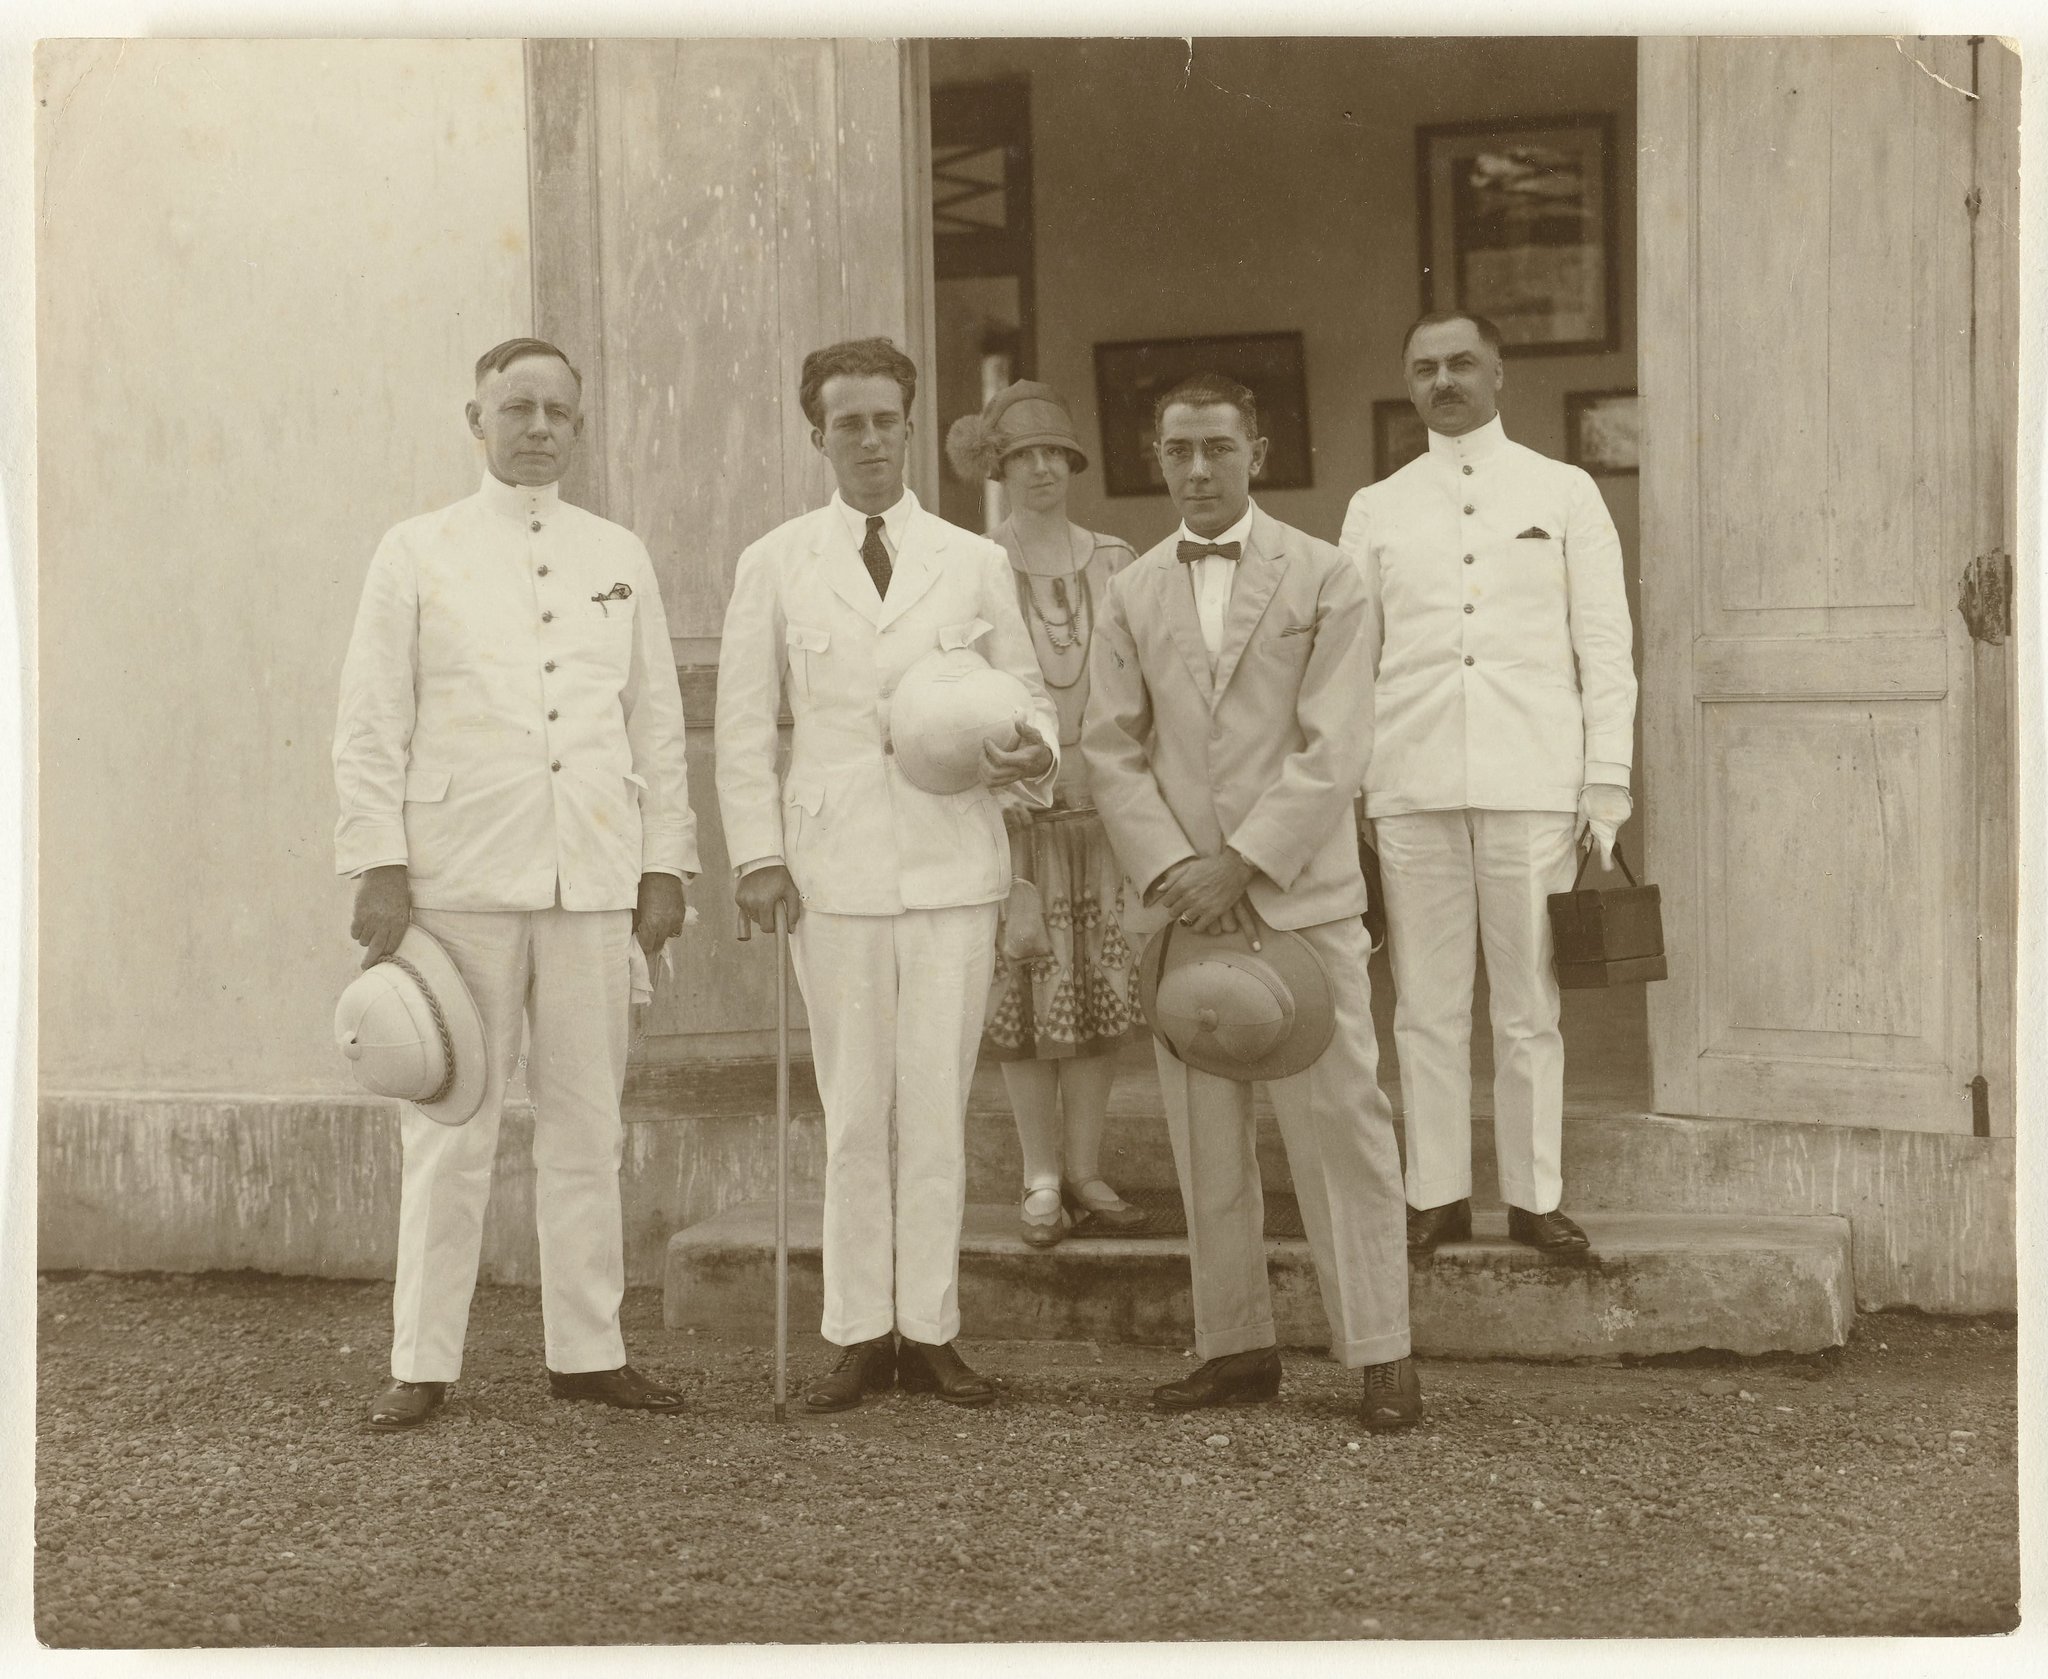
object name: photograph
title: Ontvangst van de Belgische kroonprins Leopold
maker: Anonymous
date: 1929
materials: photographic support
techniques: photography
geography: dutch east indies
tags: brussels, historical persons, dutch east indies, the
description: Ontvangst van de Belgische kroonprins Leopold met onder andere het echtpaar Letterie.